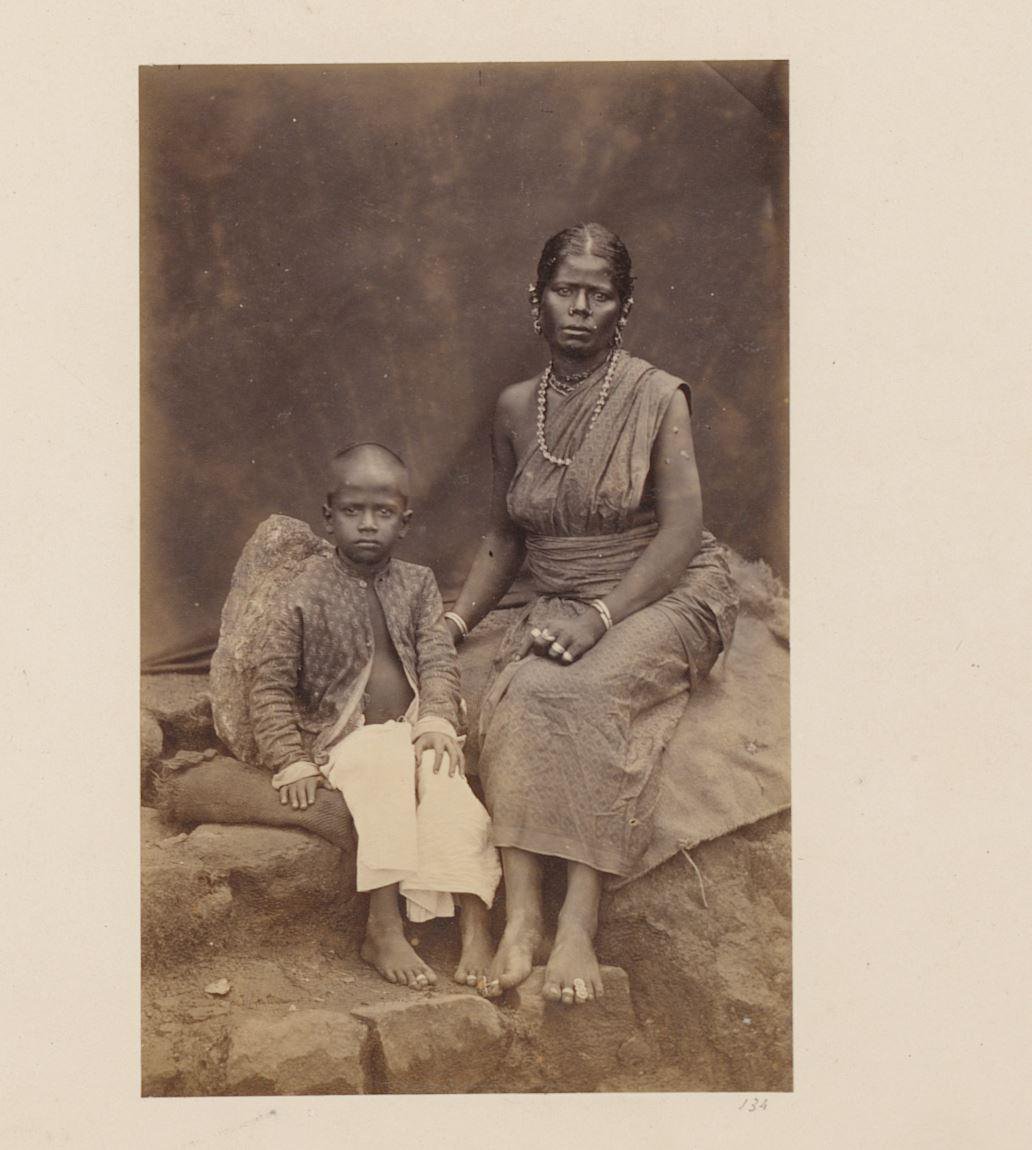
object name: photograph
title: Portrait of an unknown woman with a child, Colombo, Sri Lanka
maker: Anonymous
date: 1880-1883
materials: photographic support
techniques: albumen print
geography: colombo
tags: mother and baby or young child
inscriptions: inscription: ‘Columbo _ (Ceylan) _’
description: Onderdeel van Reisalbum met opnames van bezienswaardigheden in Egypte, Nederlands-Indië, Singapore en Ceylon.